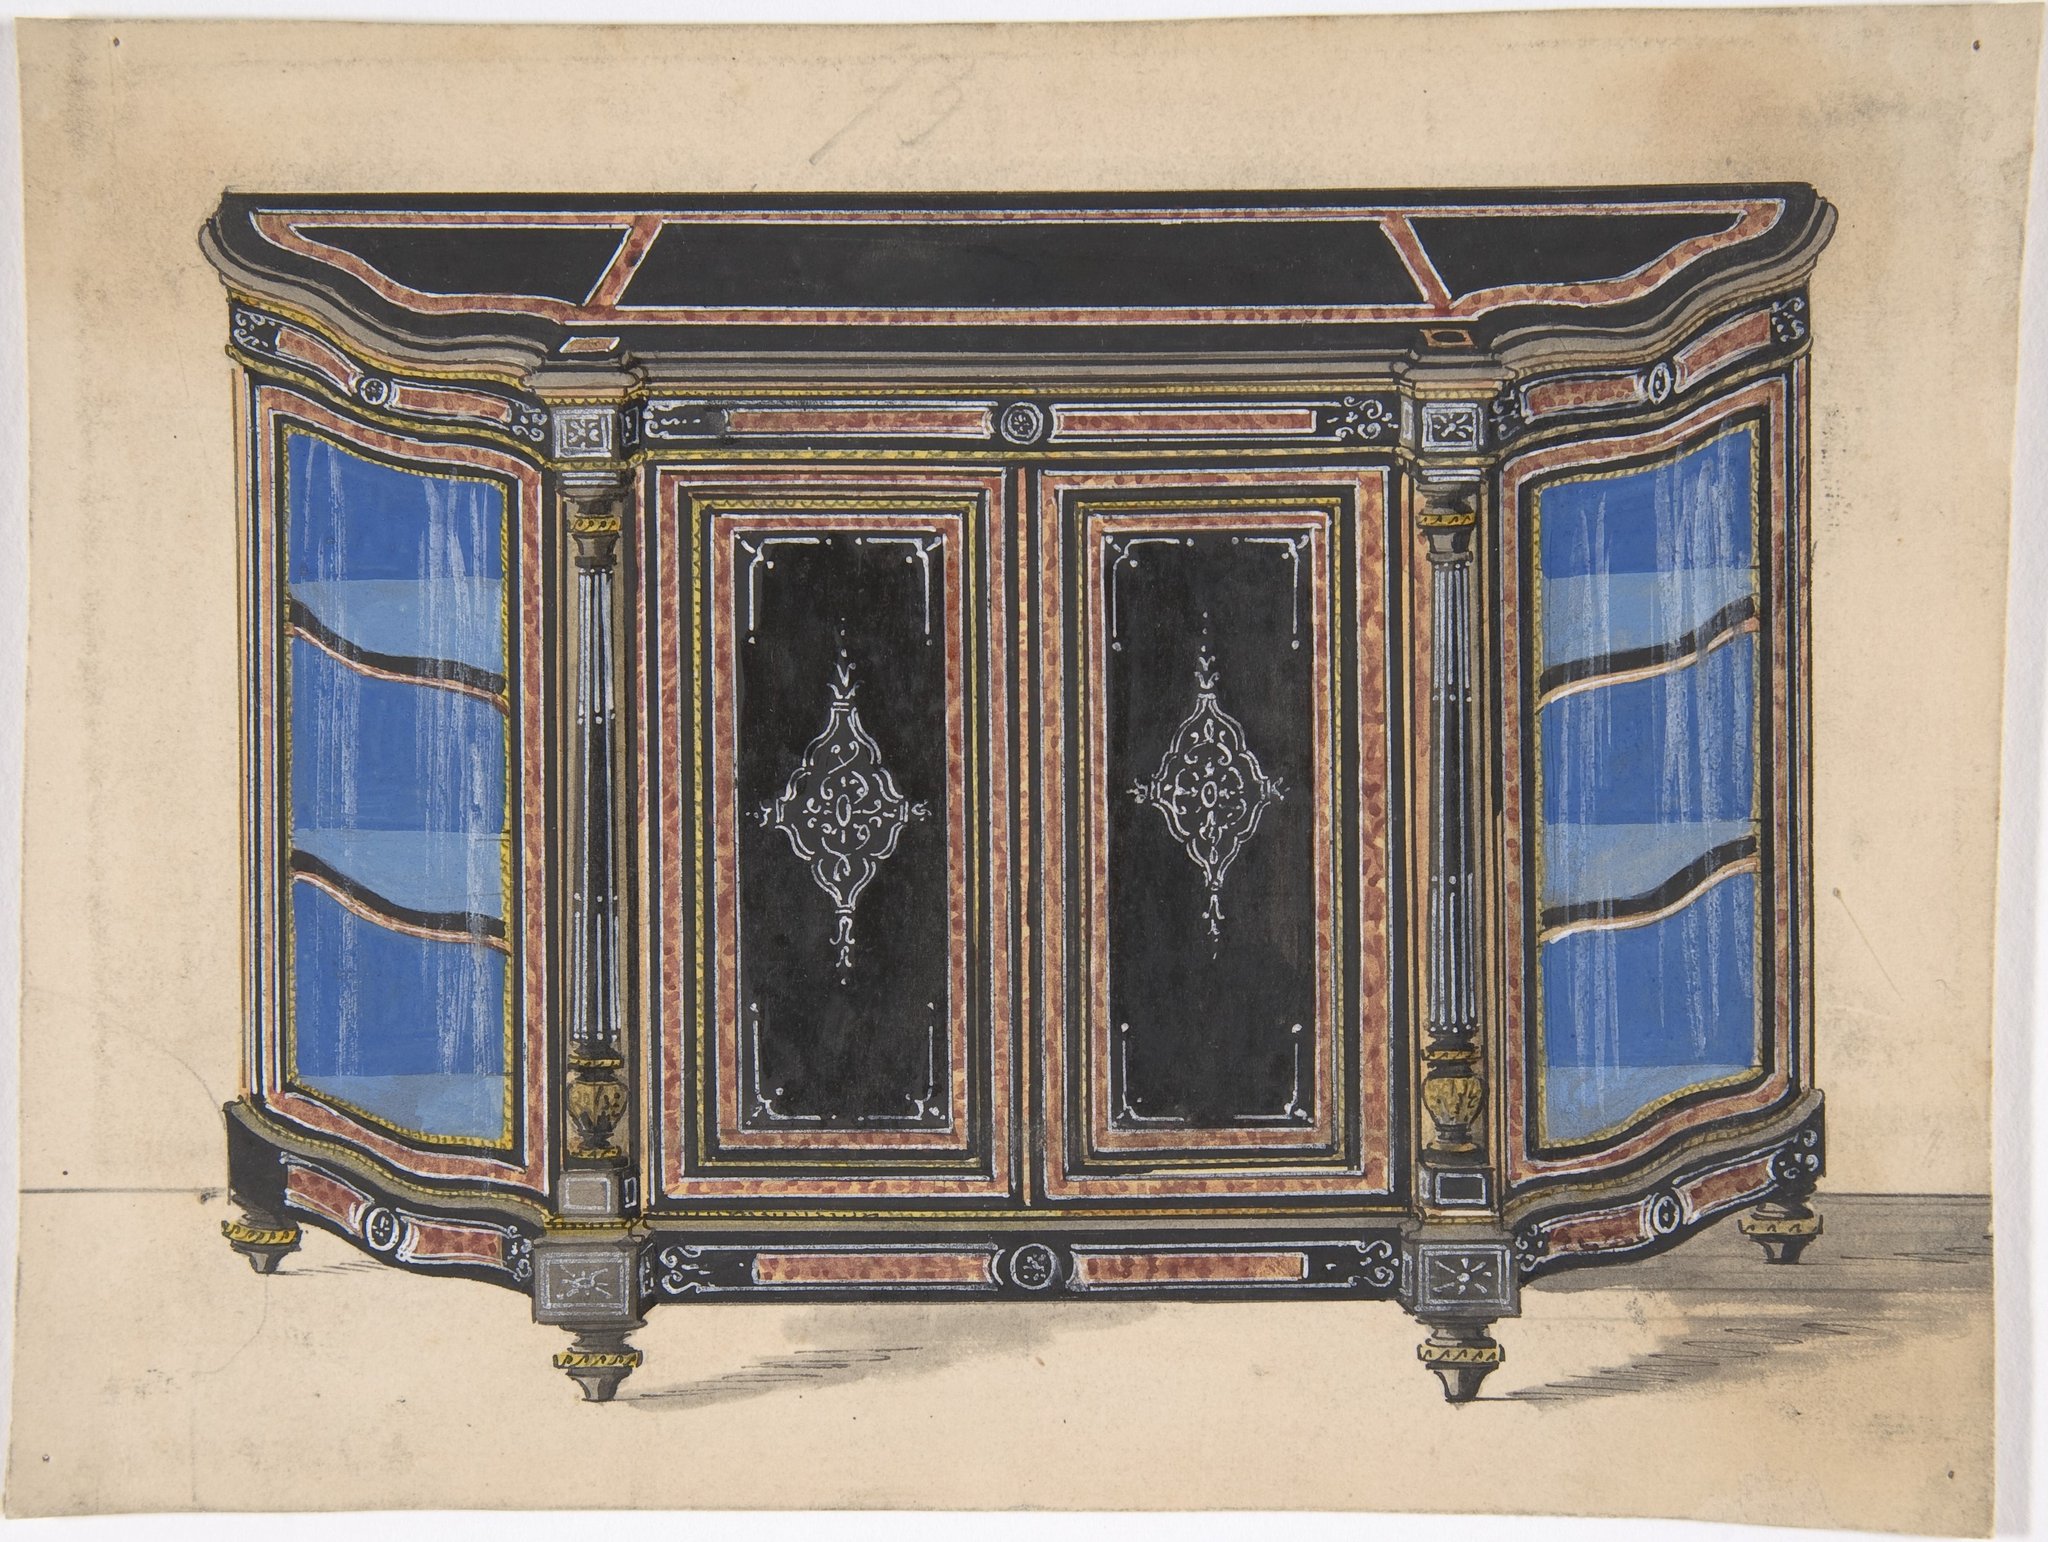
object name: drawing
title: Design for a Cabinet with a Black Top and Blue Interior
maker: anonymous, british, 19th century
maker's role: artist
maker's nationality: british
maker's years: 1800-1900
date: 1801-1900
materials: ink, watercolor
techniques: pen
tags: cabinets